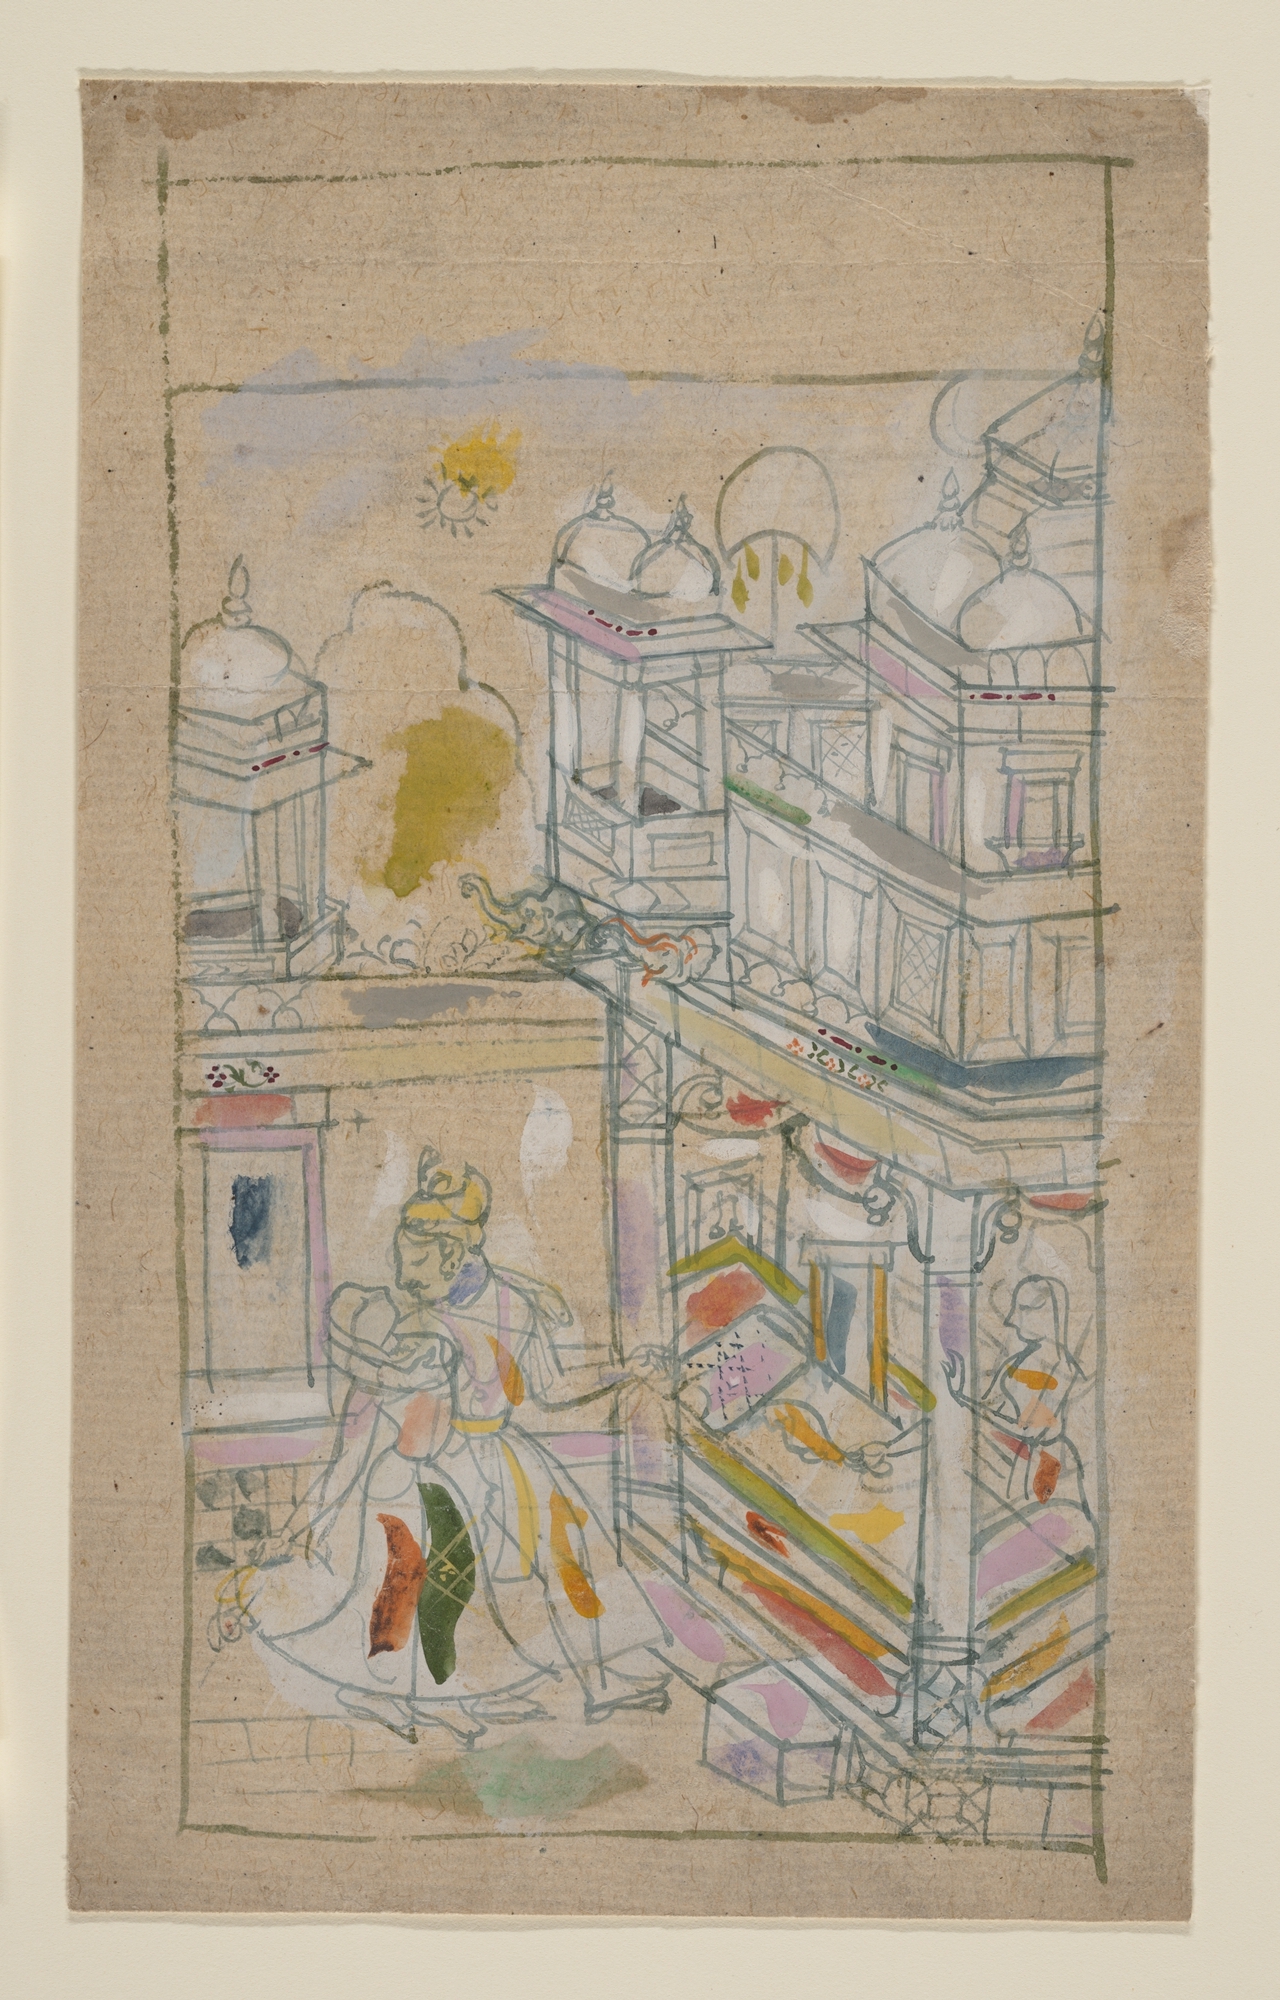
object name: painting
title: Lovers Returning to a Palace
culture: indian or rajasthan or bundi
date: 1767-1800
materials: ink, paper, watercolor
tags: palaces,couples,men,women,beds